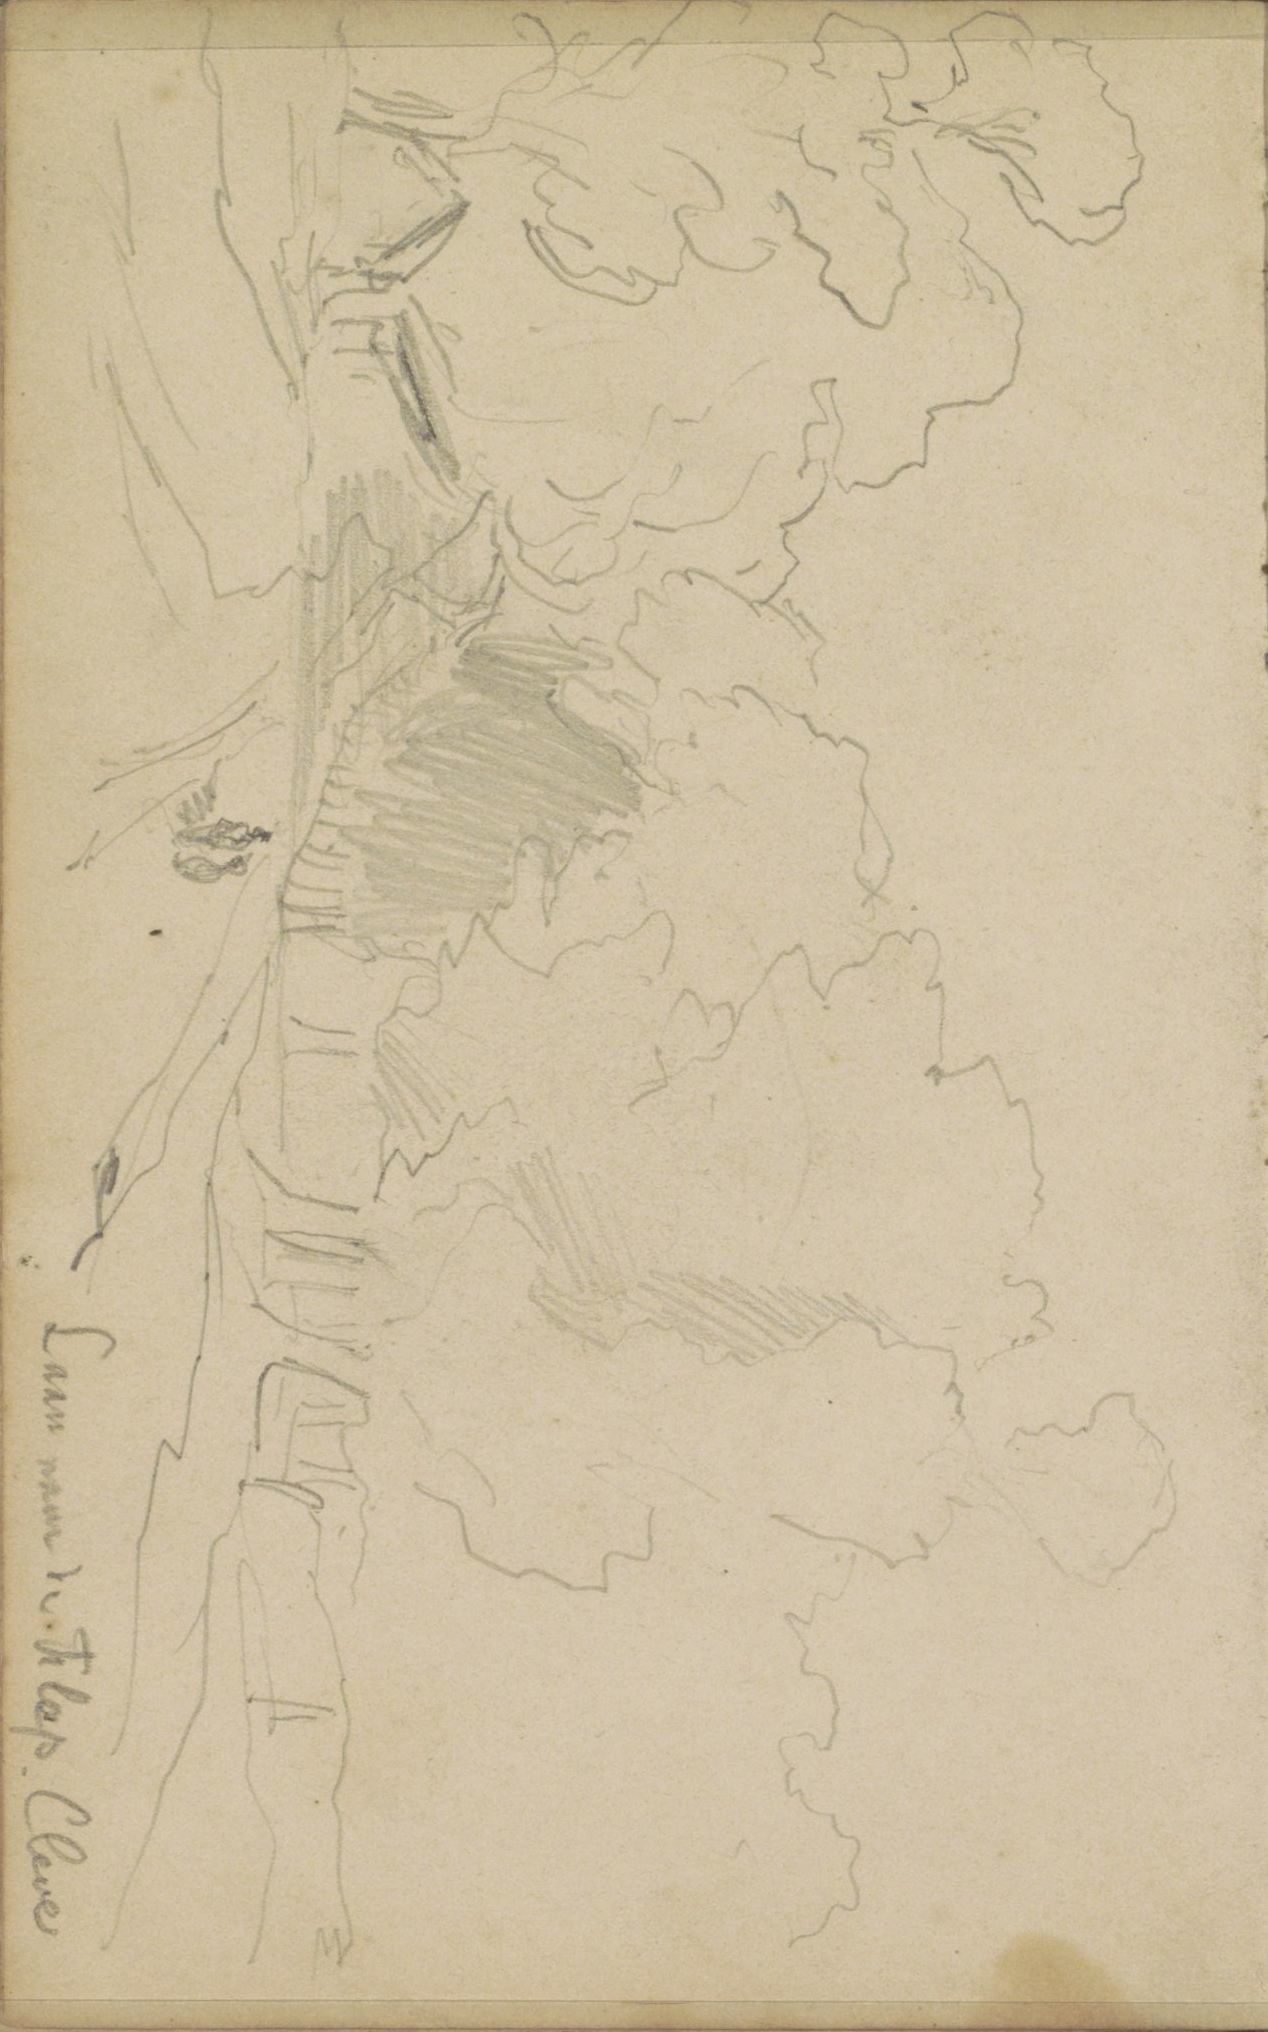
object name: sketchbook leaf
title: Figuren op een laan in de bossen van Kleef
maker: johannes tavenraat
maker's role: draughtsman, painter, print maker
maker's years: 1809-1881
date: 1839-1872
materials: paper, pencil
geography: cleves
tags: road, path, forest, wood, landscapes (+ landscape with figures, staffage), cleves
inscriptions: annotation: ‘Laan naar de [...]lep Cleve’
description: Blad 65 verso uit een schetsboek met 73 bladen.